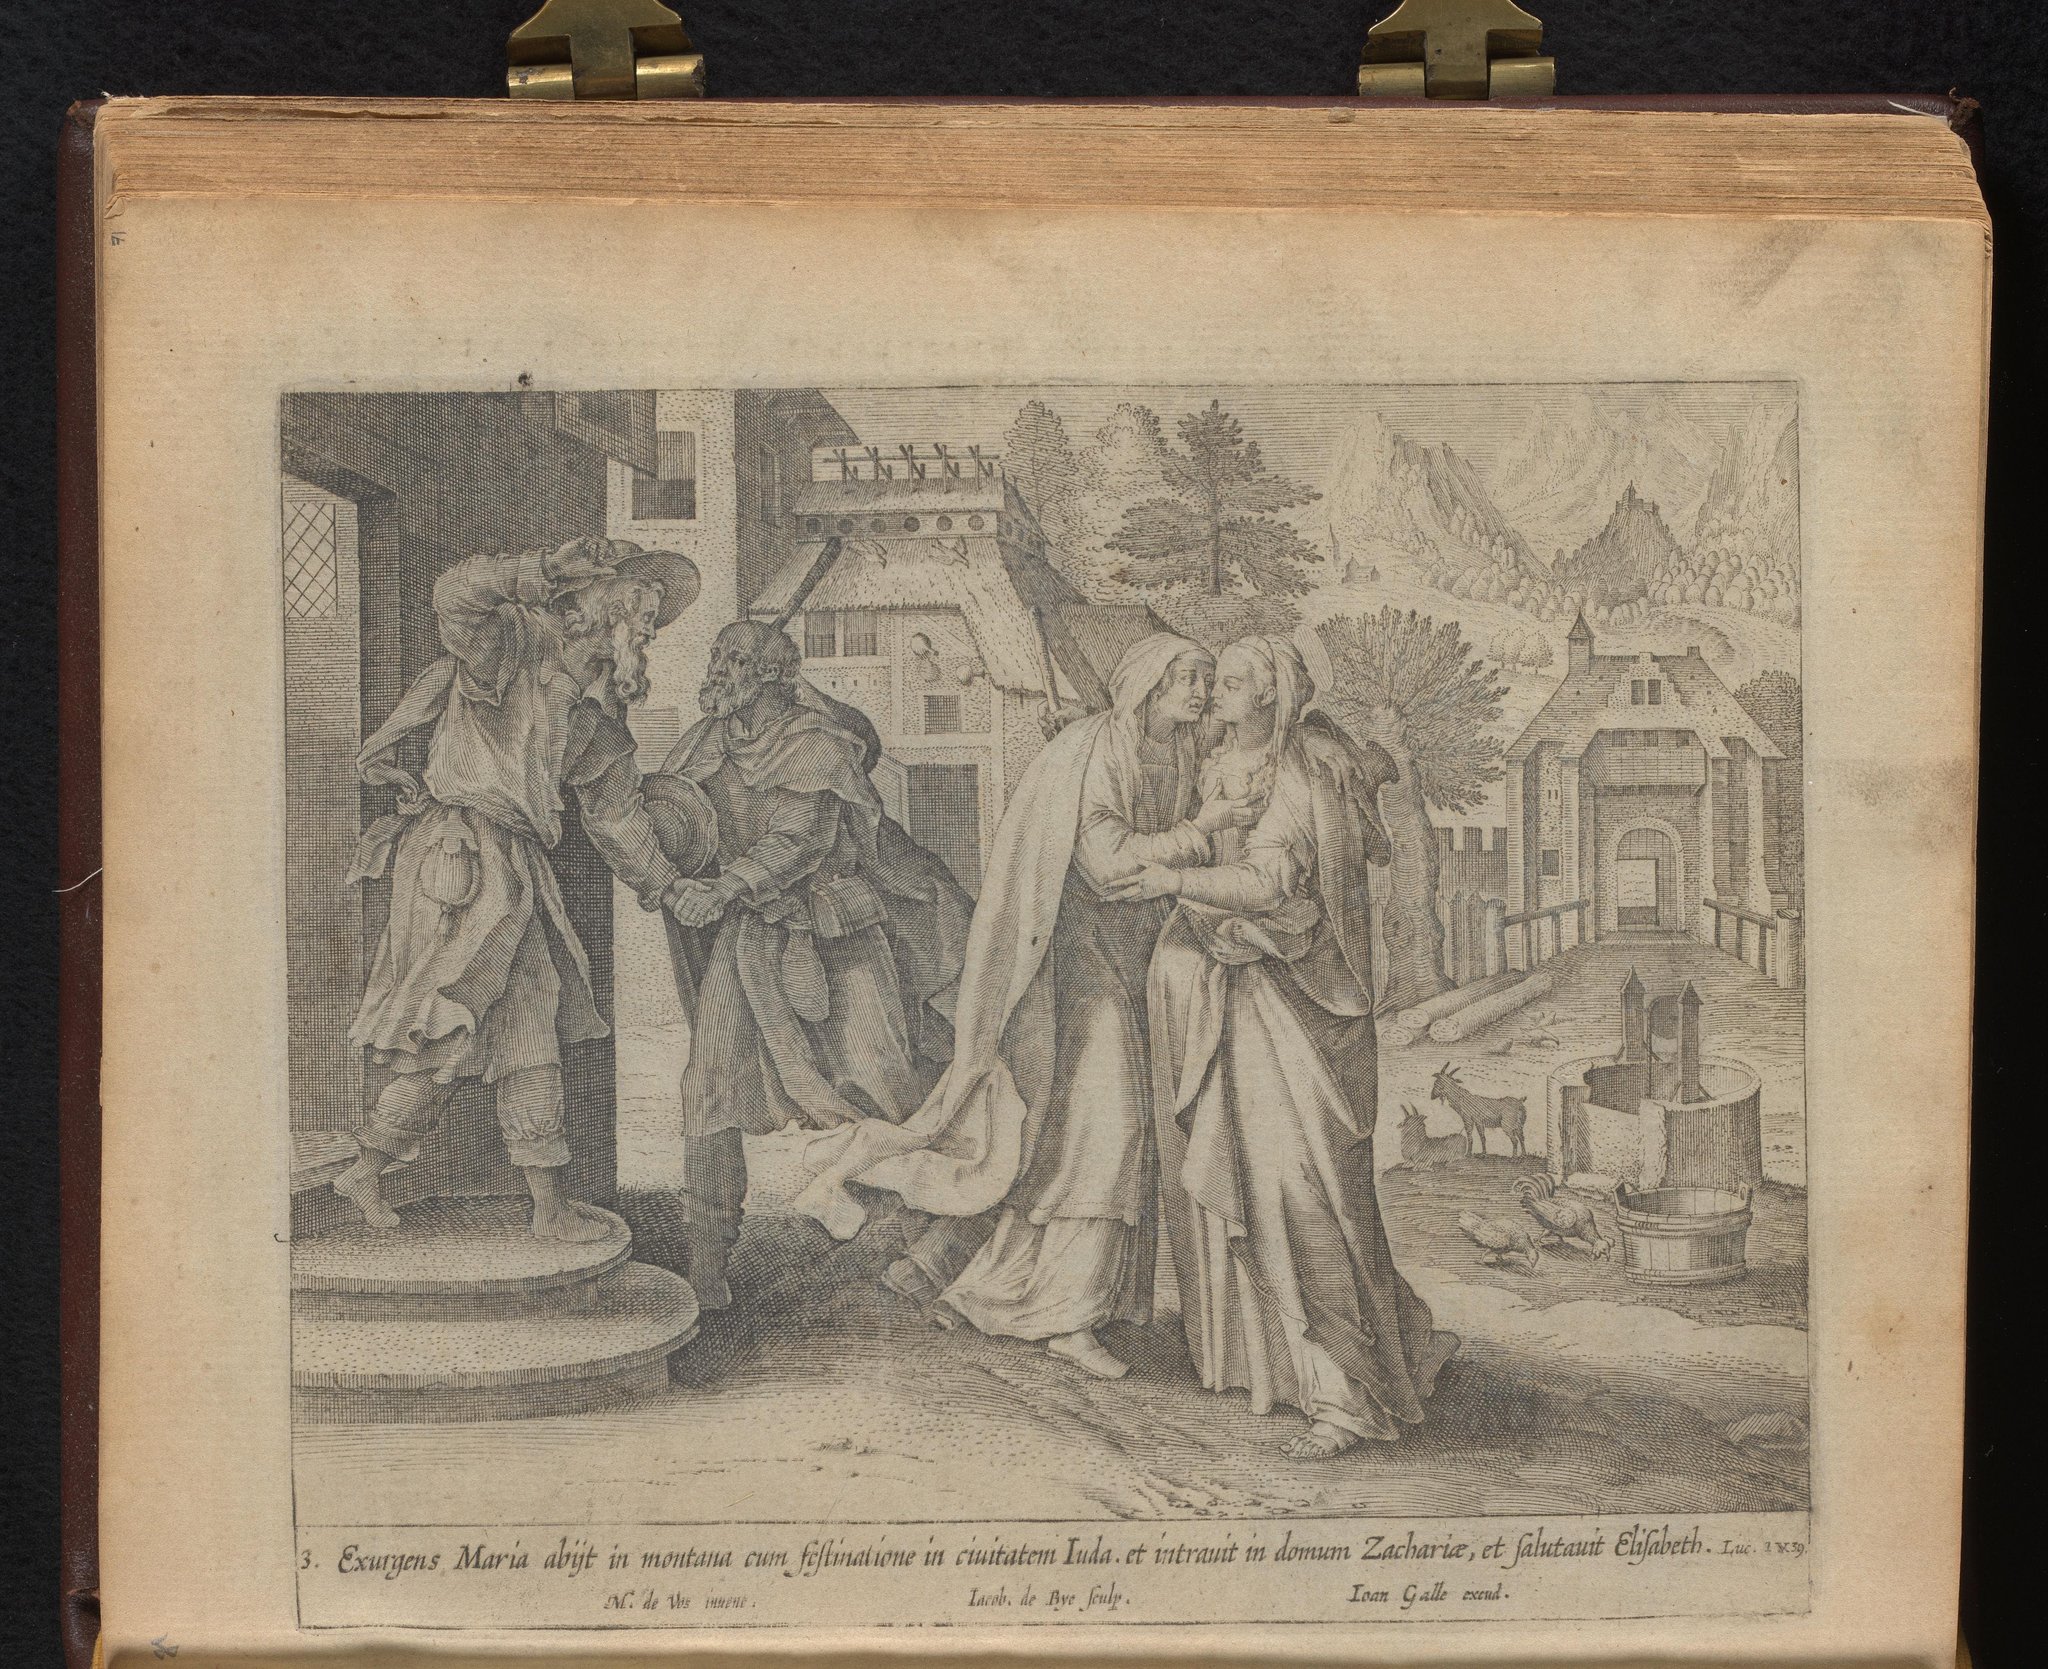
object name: print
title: Vita, passio et Resvrrectio Iesv Christi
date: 1598-1618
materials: paper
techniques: engraving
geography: antwerp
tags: visitation (possibly joseph and/or zacharias present) (luke 1:39-56)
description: Prent maakt deel uit van een prentbijbel.